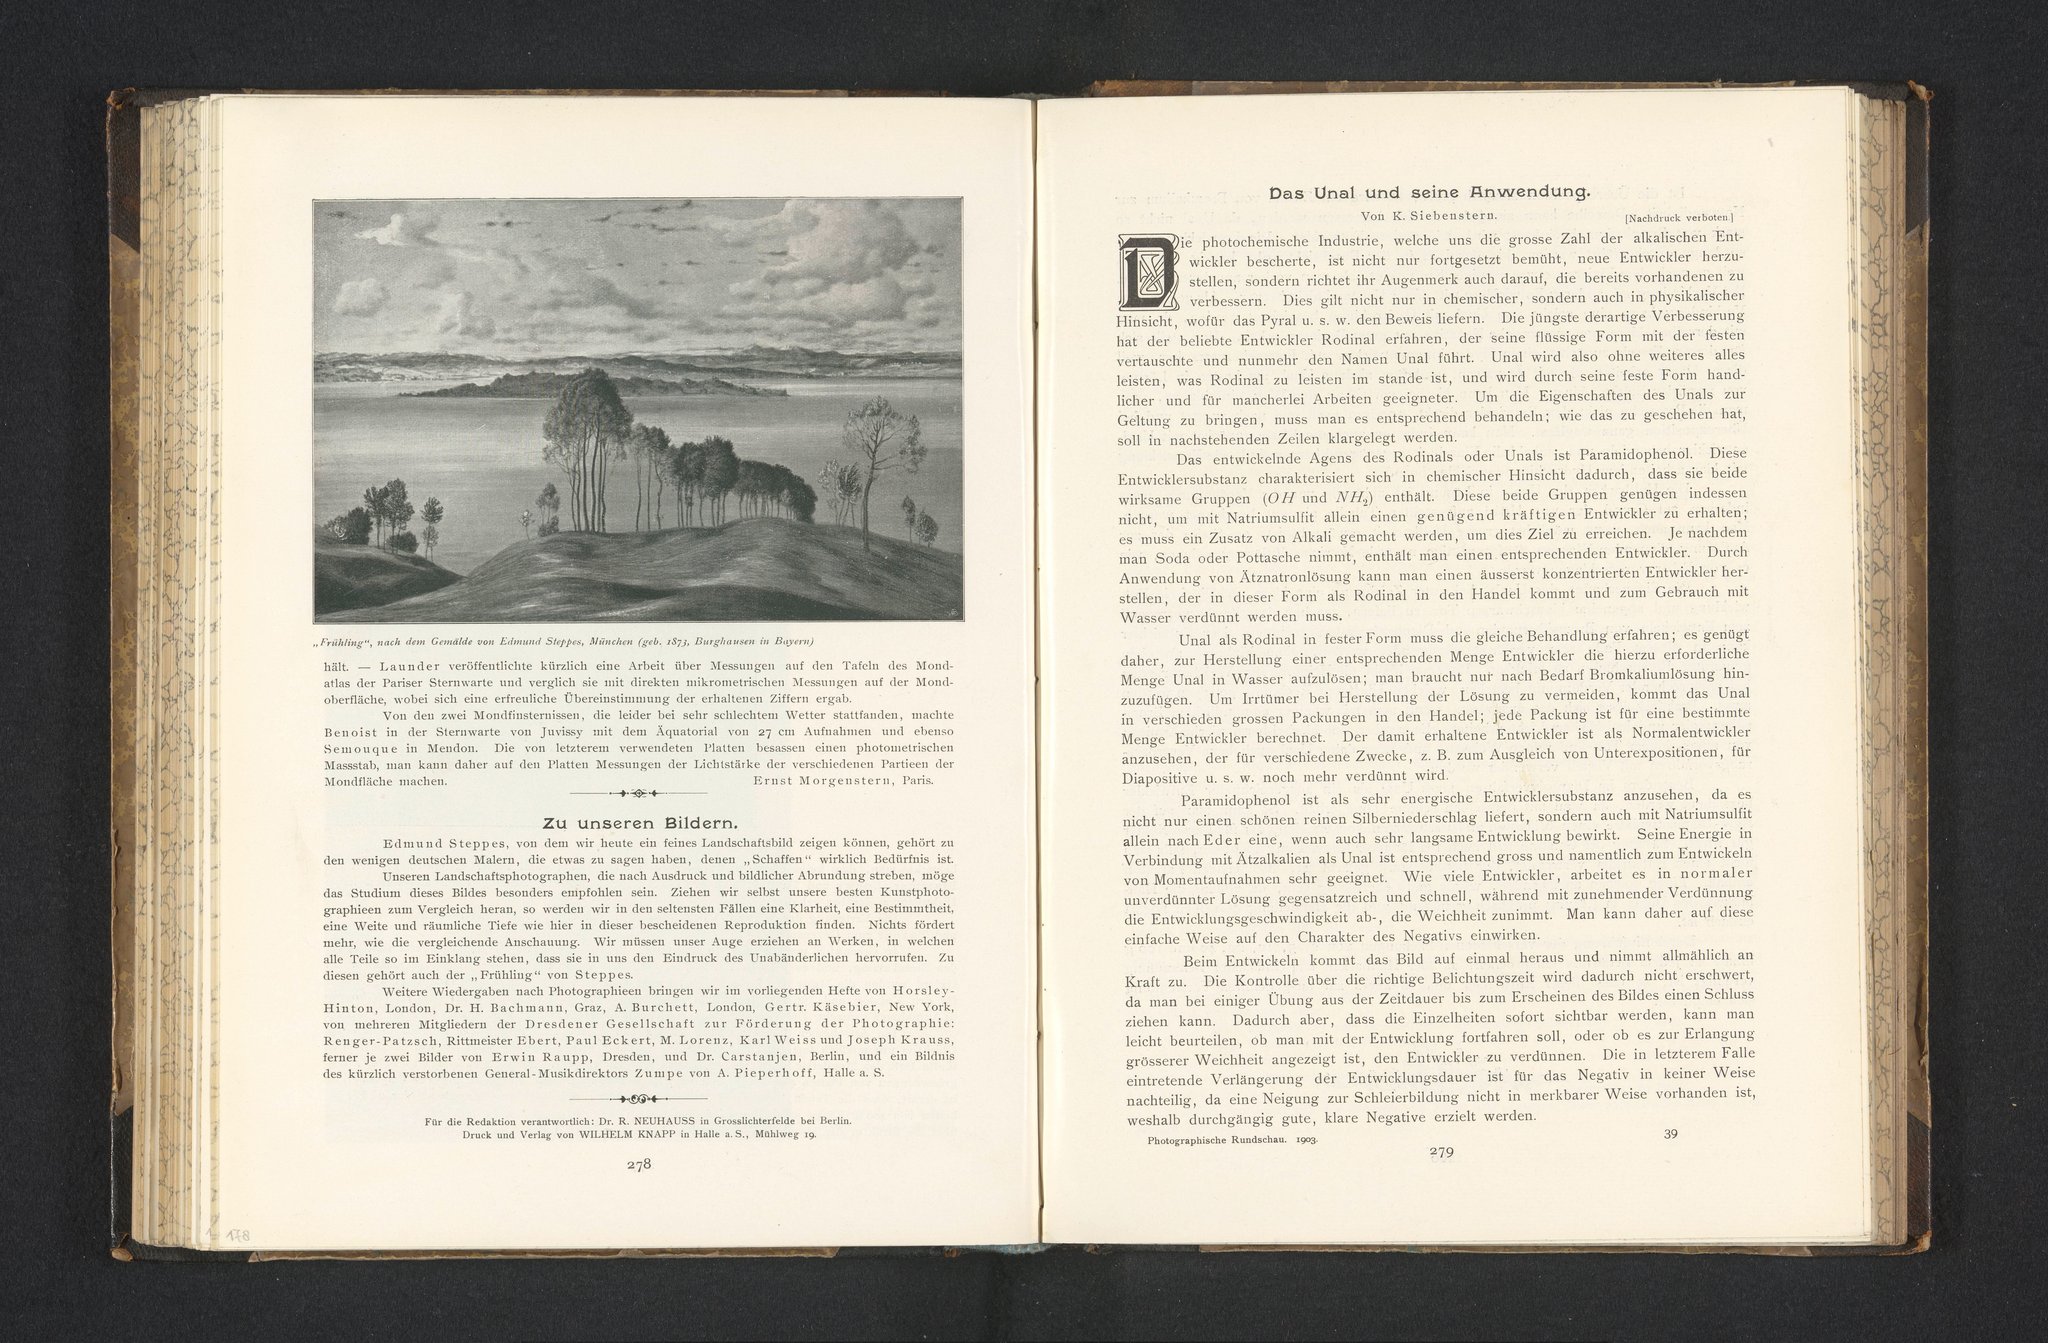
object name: photomechanical print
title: Reproductie van een schilderij door Edmund Steppes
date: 1898-1903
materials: paper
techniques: autotype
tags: landscapes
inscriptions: monogram: ‘AB/ M’